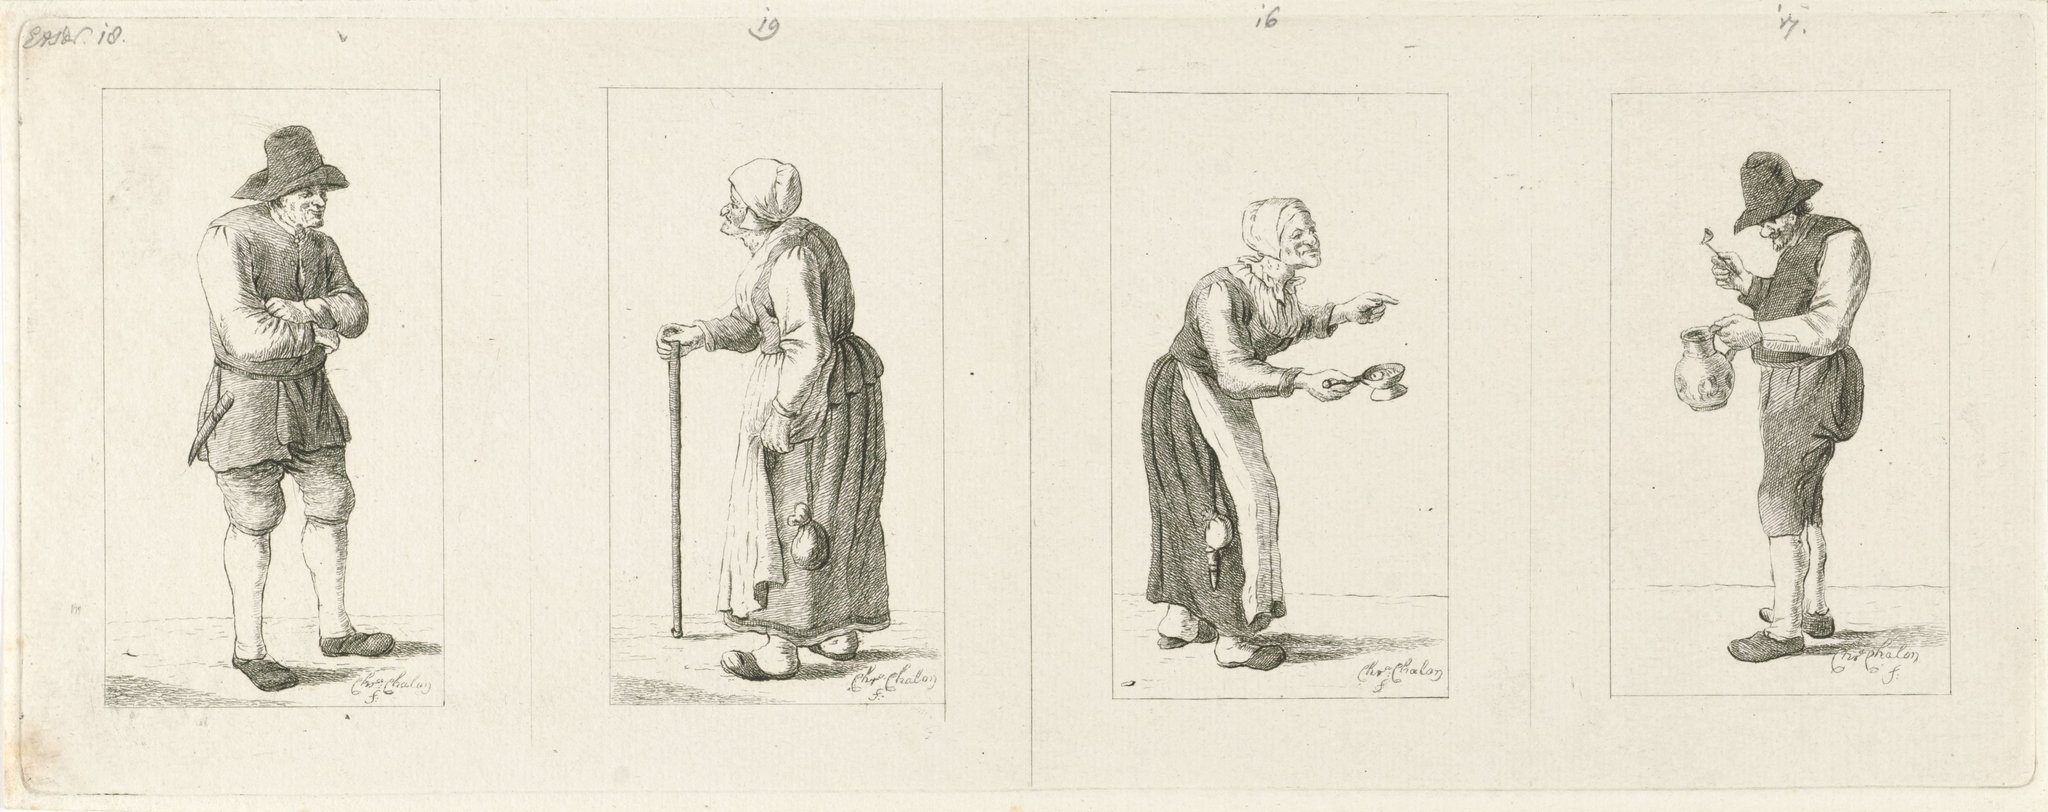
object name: print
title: Vier voorstellingen van een staande figuur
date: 1779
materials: paper, pencil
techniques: etching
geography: leiden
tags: standing figure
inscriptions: number: ‘Etsdr. 18. 19. 16. 17.’, collector's mark: Lugt 240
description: Vier voorstellingen van een staande figuur: een man met de armen over elkaar, een vrouw met een stok en een beurs, een vrouw wijzend met in haar hand een vuurtest met een brandend kooltje en een man met een pijp en een kruik.